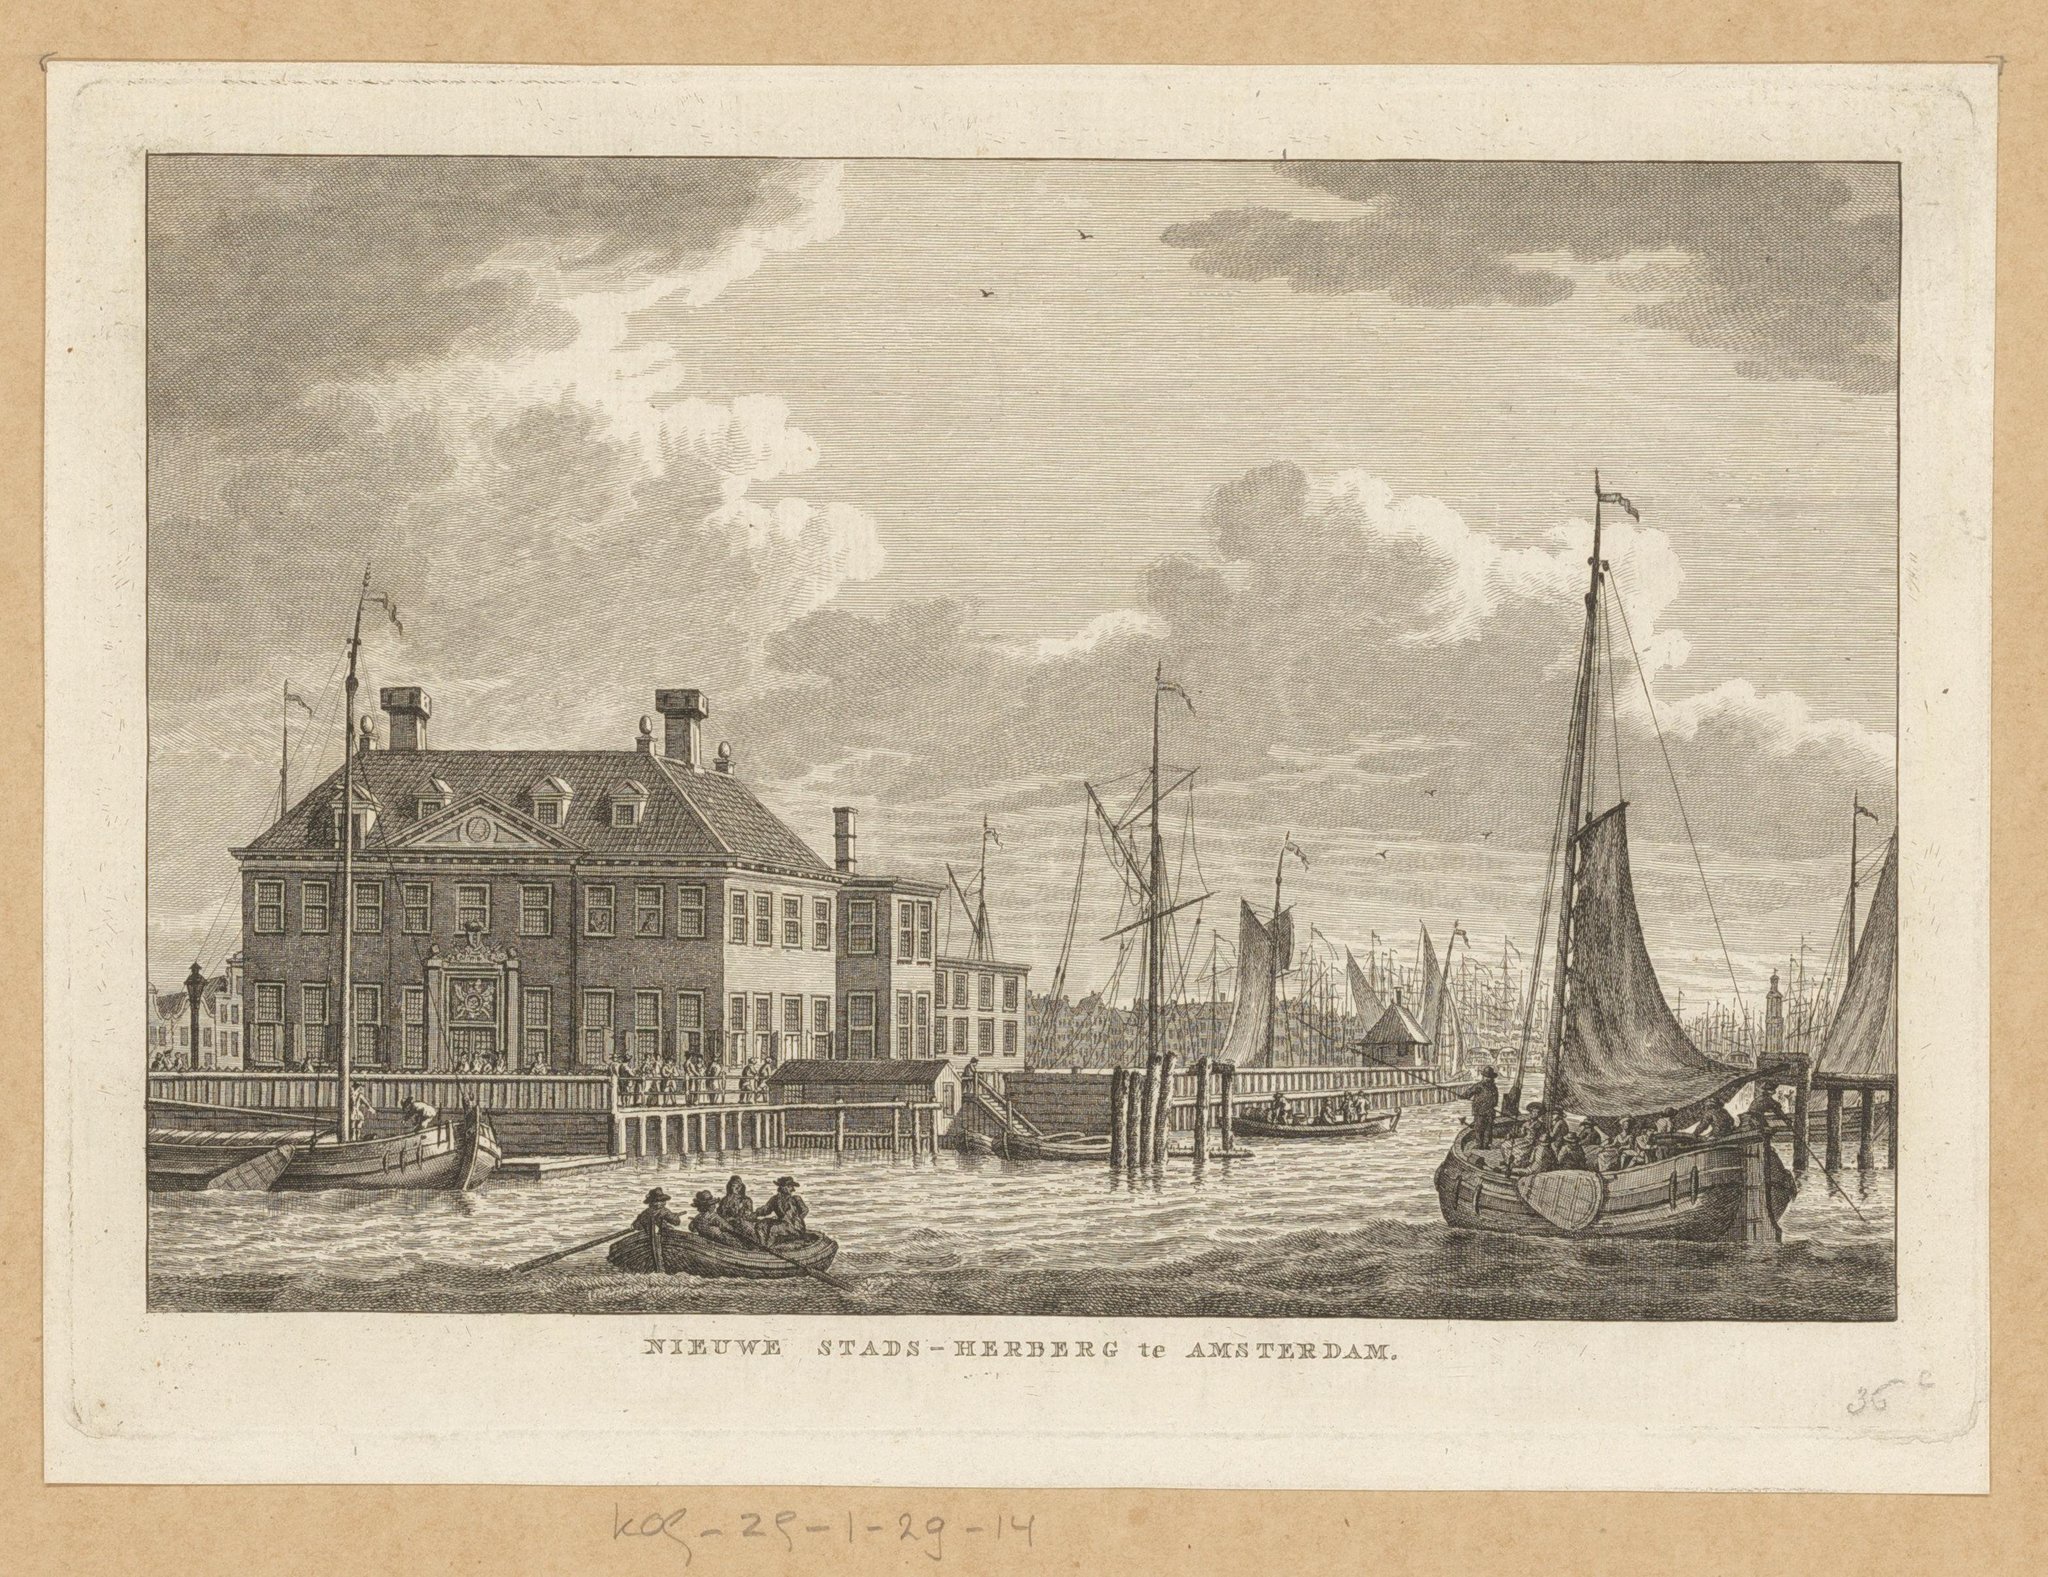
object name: print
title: Gezicht op de Nieuwe Stadsherberg aan het IJ in Amsterdam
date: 1786-1825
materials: paper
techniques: engraving, etching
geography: amsterdam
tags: sailing-ship, sailing-boat, inn, coffee-house, public house, etc., rowing facing backward, pulling, bridge in city across river, canal, etc., amsterdam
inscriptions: stamp, stamp, collector's mark: Lugt 1641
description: Huidige staat van prent gebruikt in: Vaderlandsche gezichten, of afbeeldingen van den tegenwoordigen staat der Vereenigde Nederlanden (…). Amsterdam: Hendrik Gartman, Willem Vermandel en Jan Willem Smit, 1786-1792. Uitgegeven in afleveringen met ieder een eigen bifolium en inhoudsopgave. Alle prenten in deze publicatie zijn gegraveerd door Carel Frederik Bendorp (I) en, in de meeste gevallen, gebaseerd op tekeningen van Jan Bulthuis. Latere staat van huidige prent, met gedrukte Franse titel, is uitgegeven als onderdeel van een plaatwerk uit ca. 1824-1825 met 74 (ongenummerde) platen van de belangrijkste topografische gezichten en verschillende zeden en gewoonten in het Verenigd Koninkrijk der Nederlanden, getiteld 'Tableau des principales vues des palais et édifices : représentations et des coutumes et usages, dans les provinces septentrionales du Royaume des Pays-Bas'. De opschriften in pen wijzen op een mogelijke voorbereiding op deze latere staat.